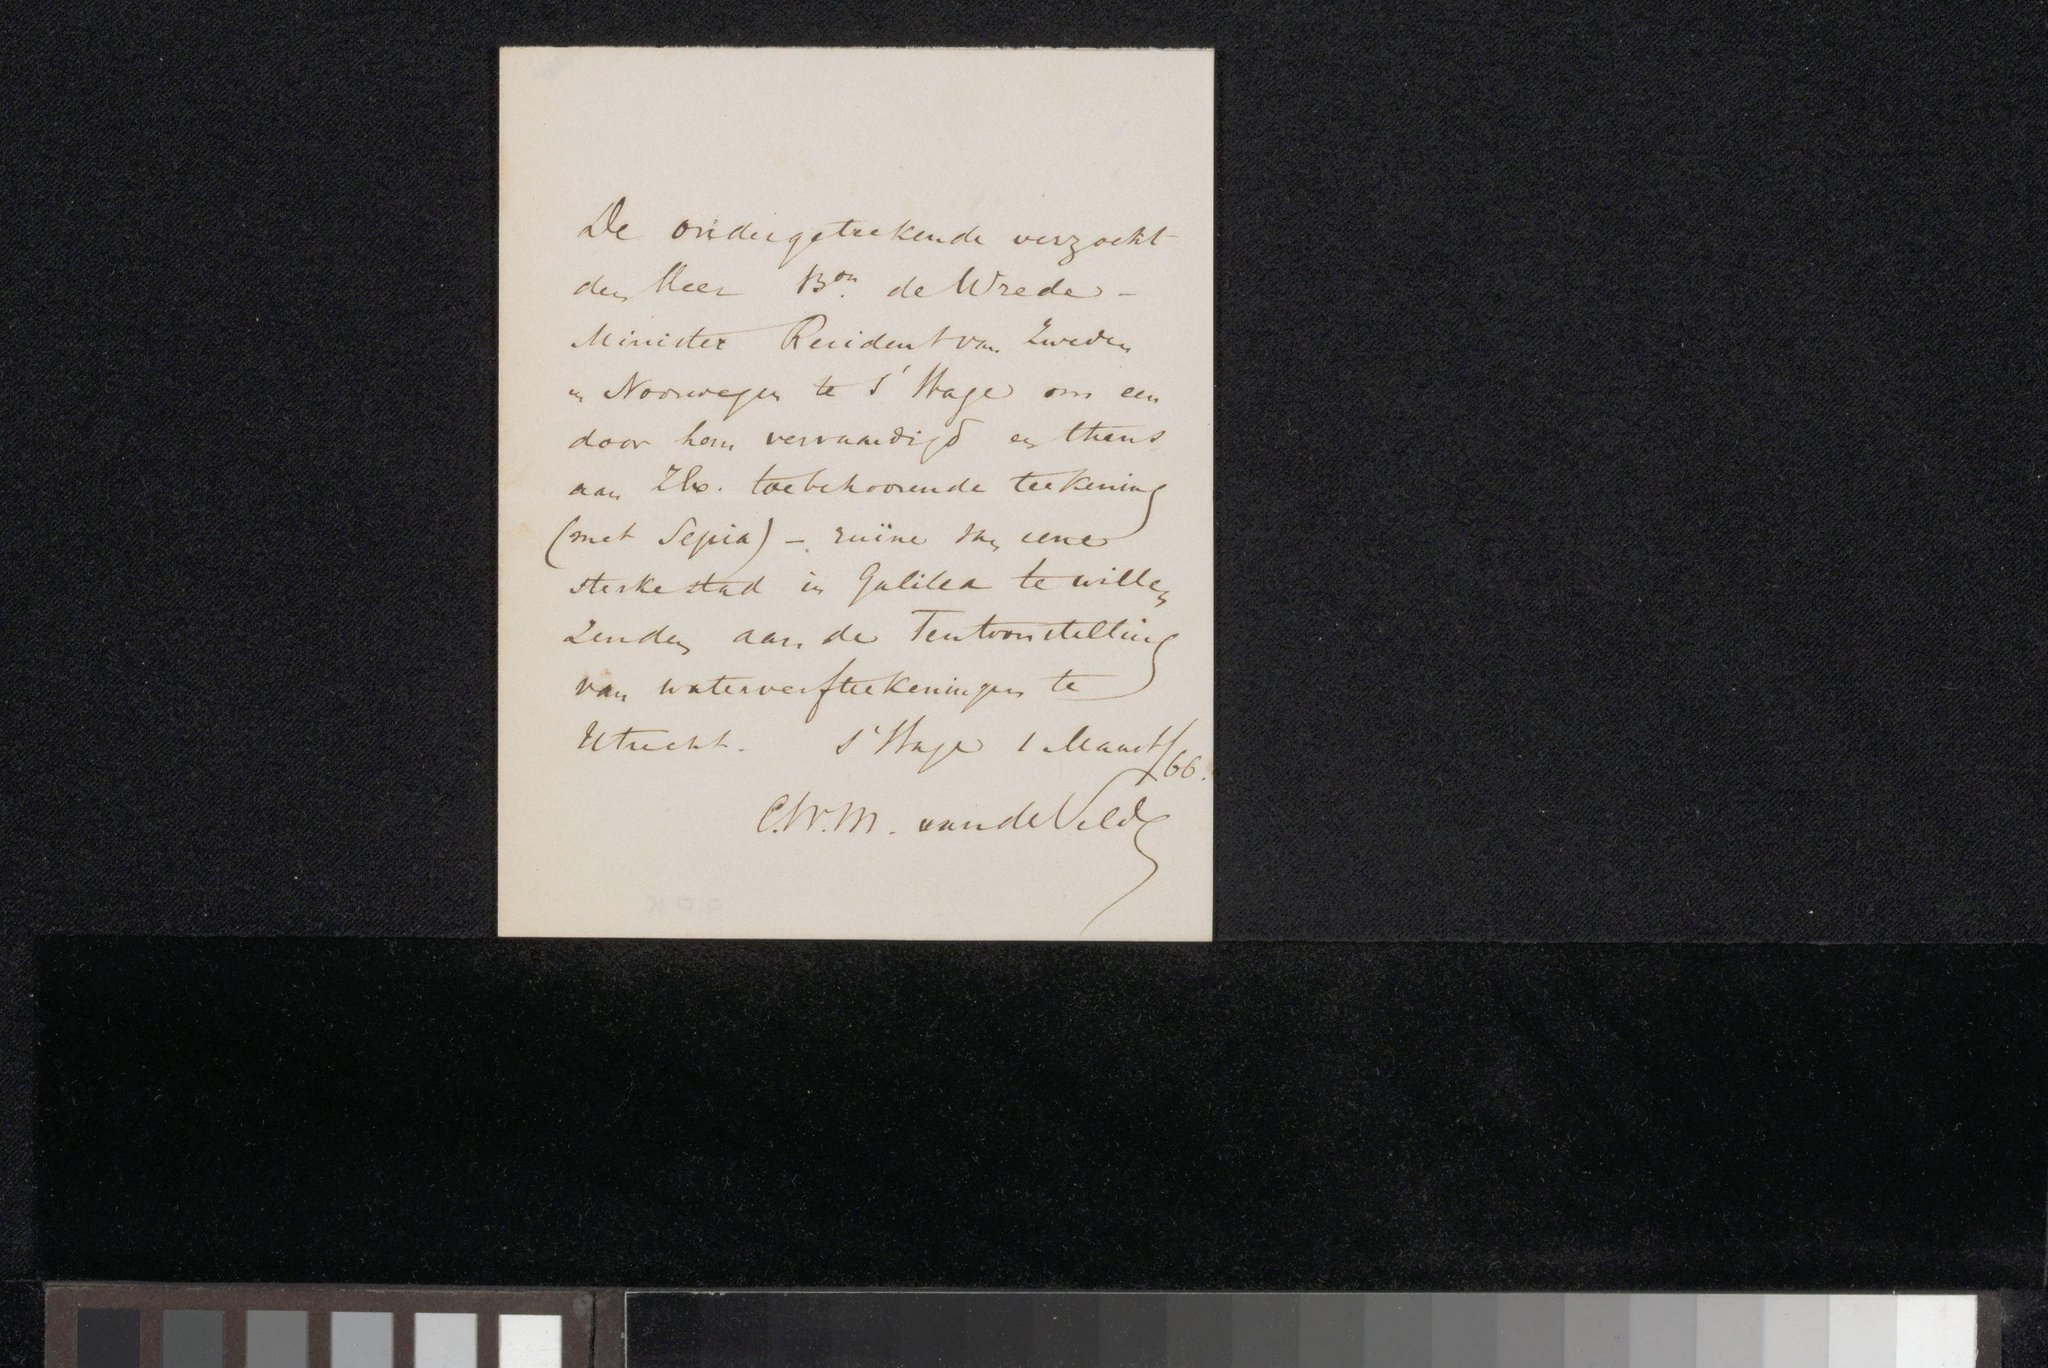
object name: letter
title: Brief aan onbekend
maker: charles william meredith van de velde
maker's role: draughtsman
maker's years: 1818-1898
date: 1866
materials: ink, paper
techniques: pen, writing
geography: the hague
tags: drawing, exhibition ~ art, utrecht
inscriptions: collector's mark: ‘RPK’